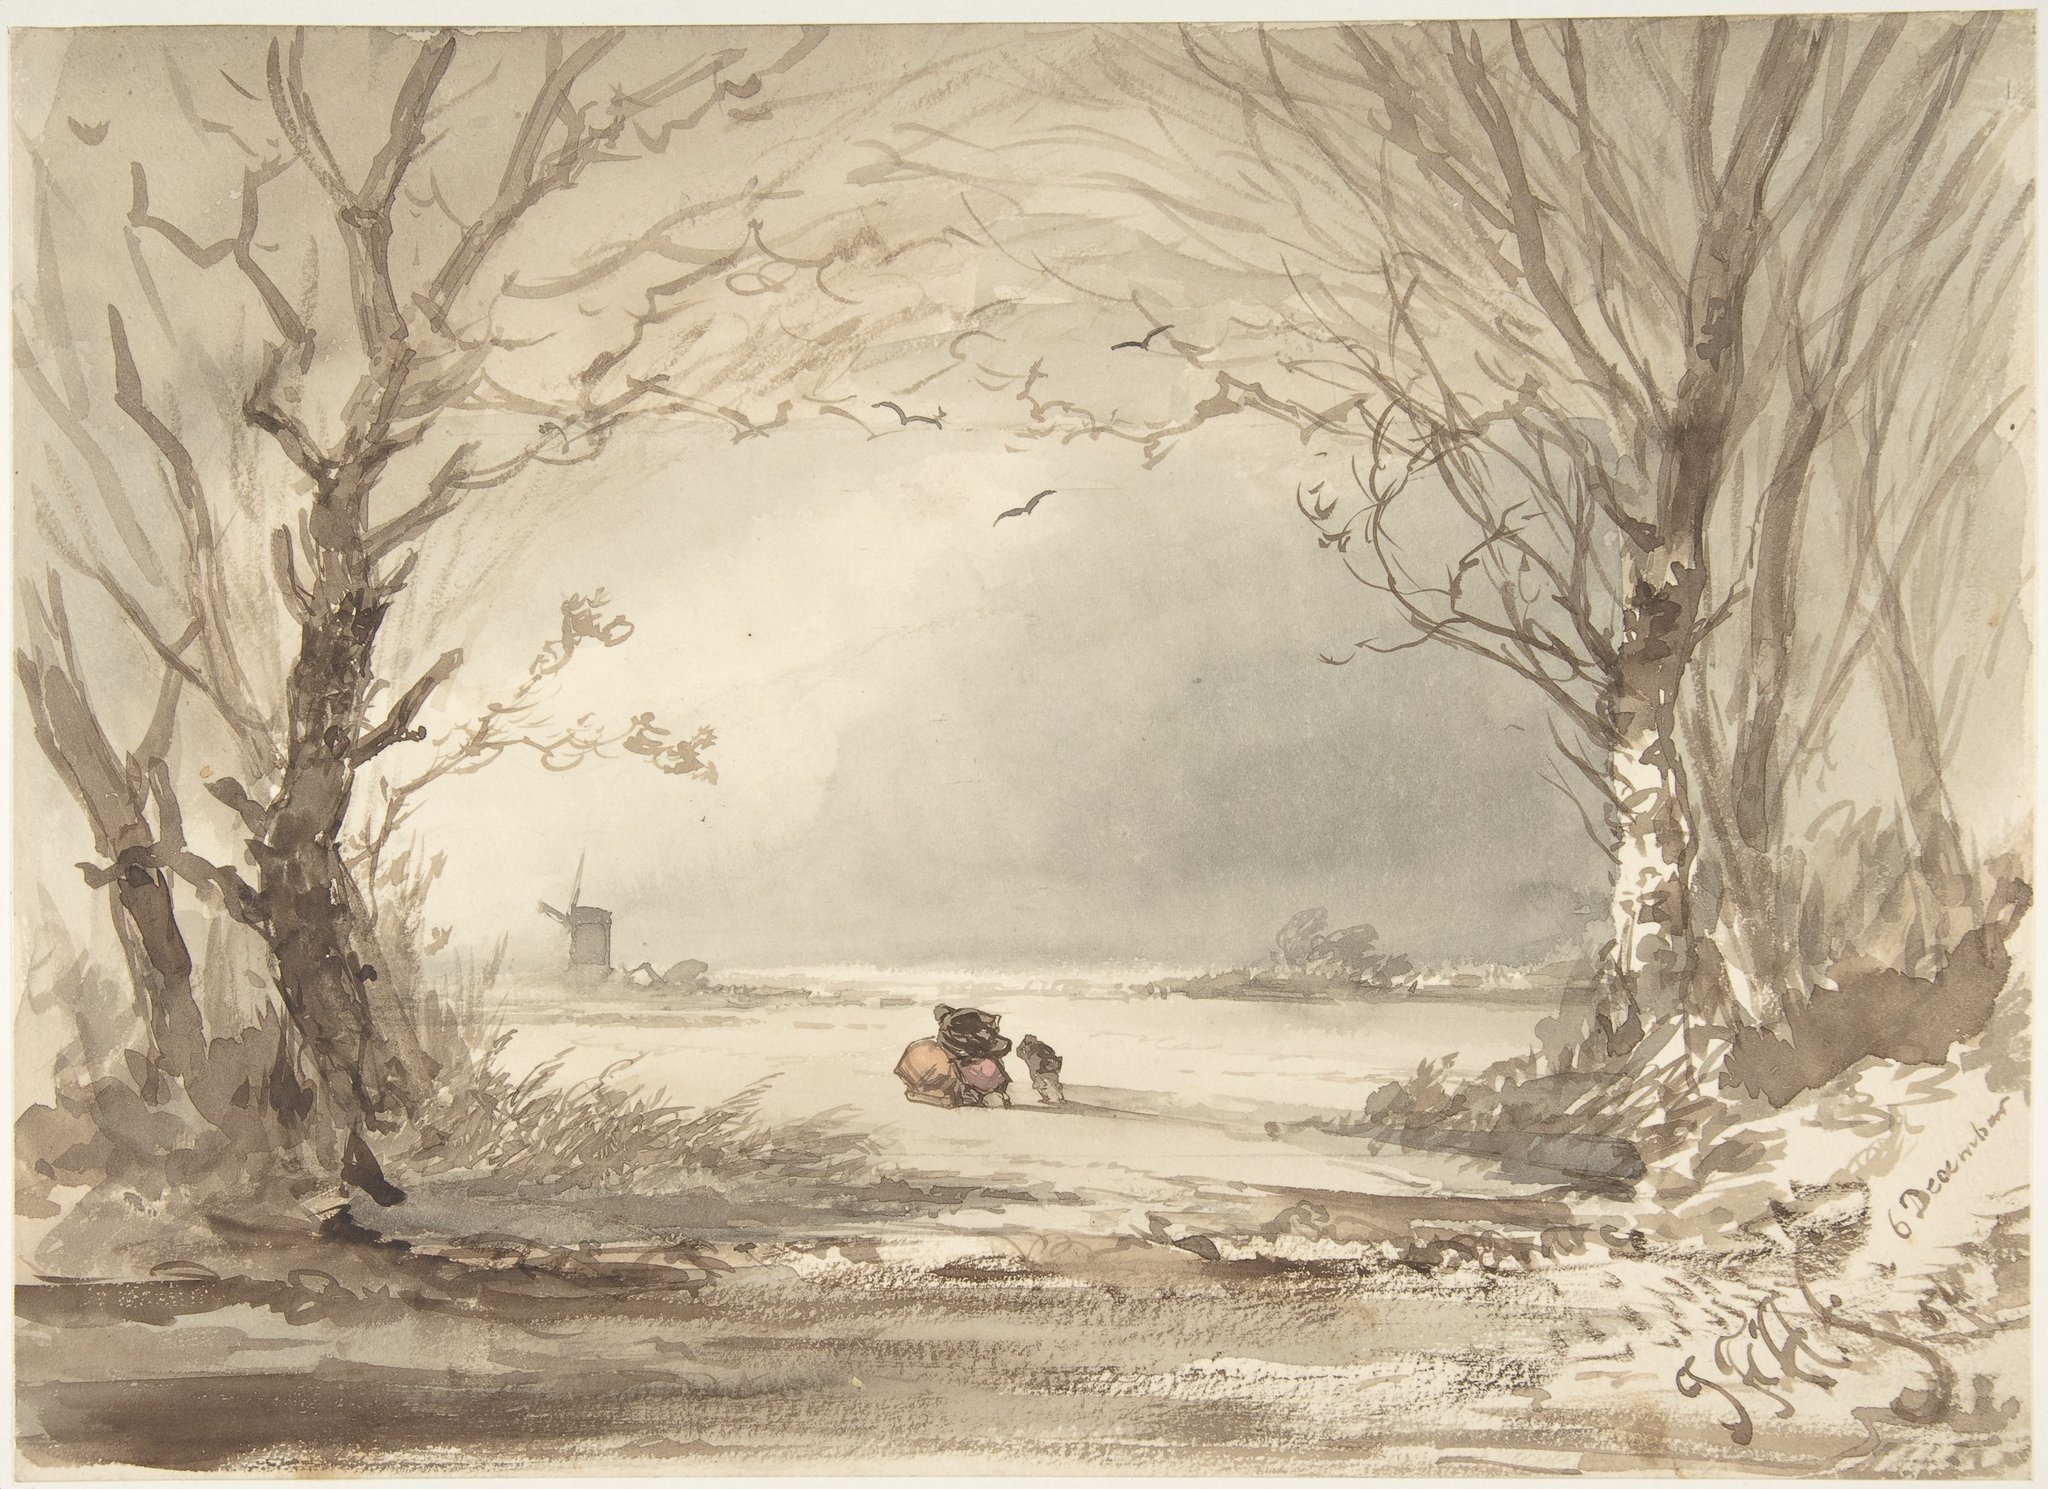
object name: drawing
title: A Winter Landscape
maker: johannes franciscus hoppenbrouwers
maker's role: draughtsman, painter, print maker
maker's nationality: dutch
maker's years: 1819-1866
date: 1854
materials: watercolor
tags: landscapes,trees,winter